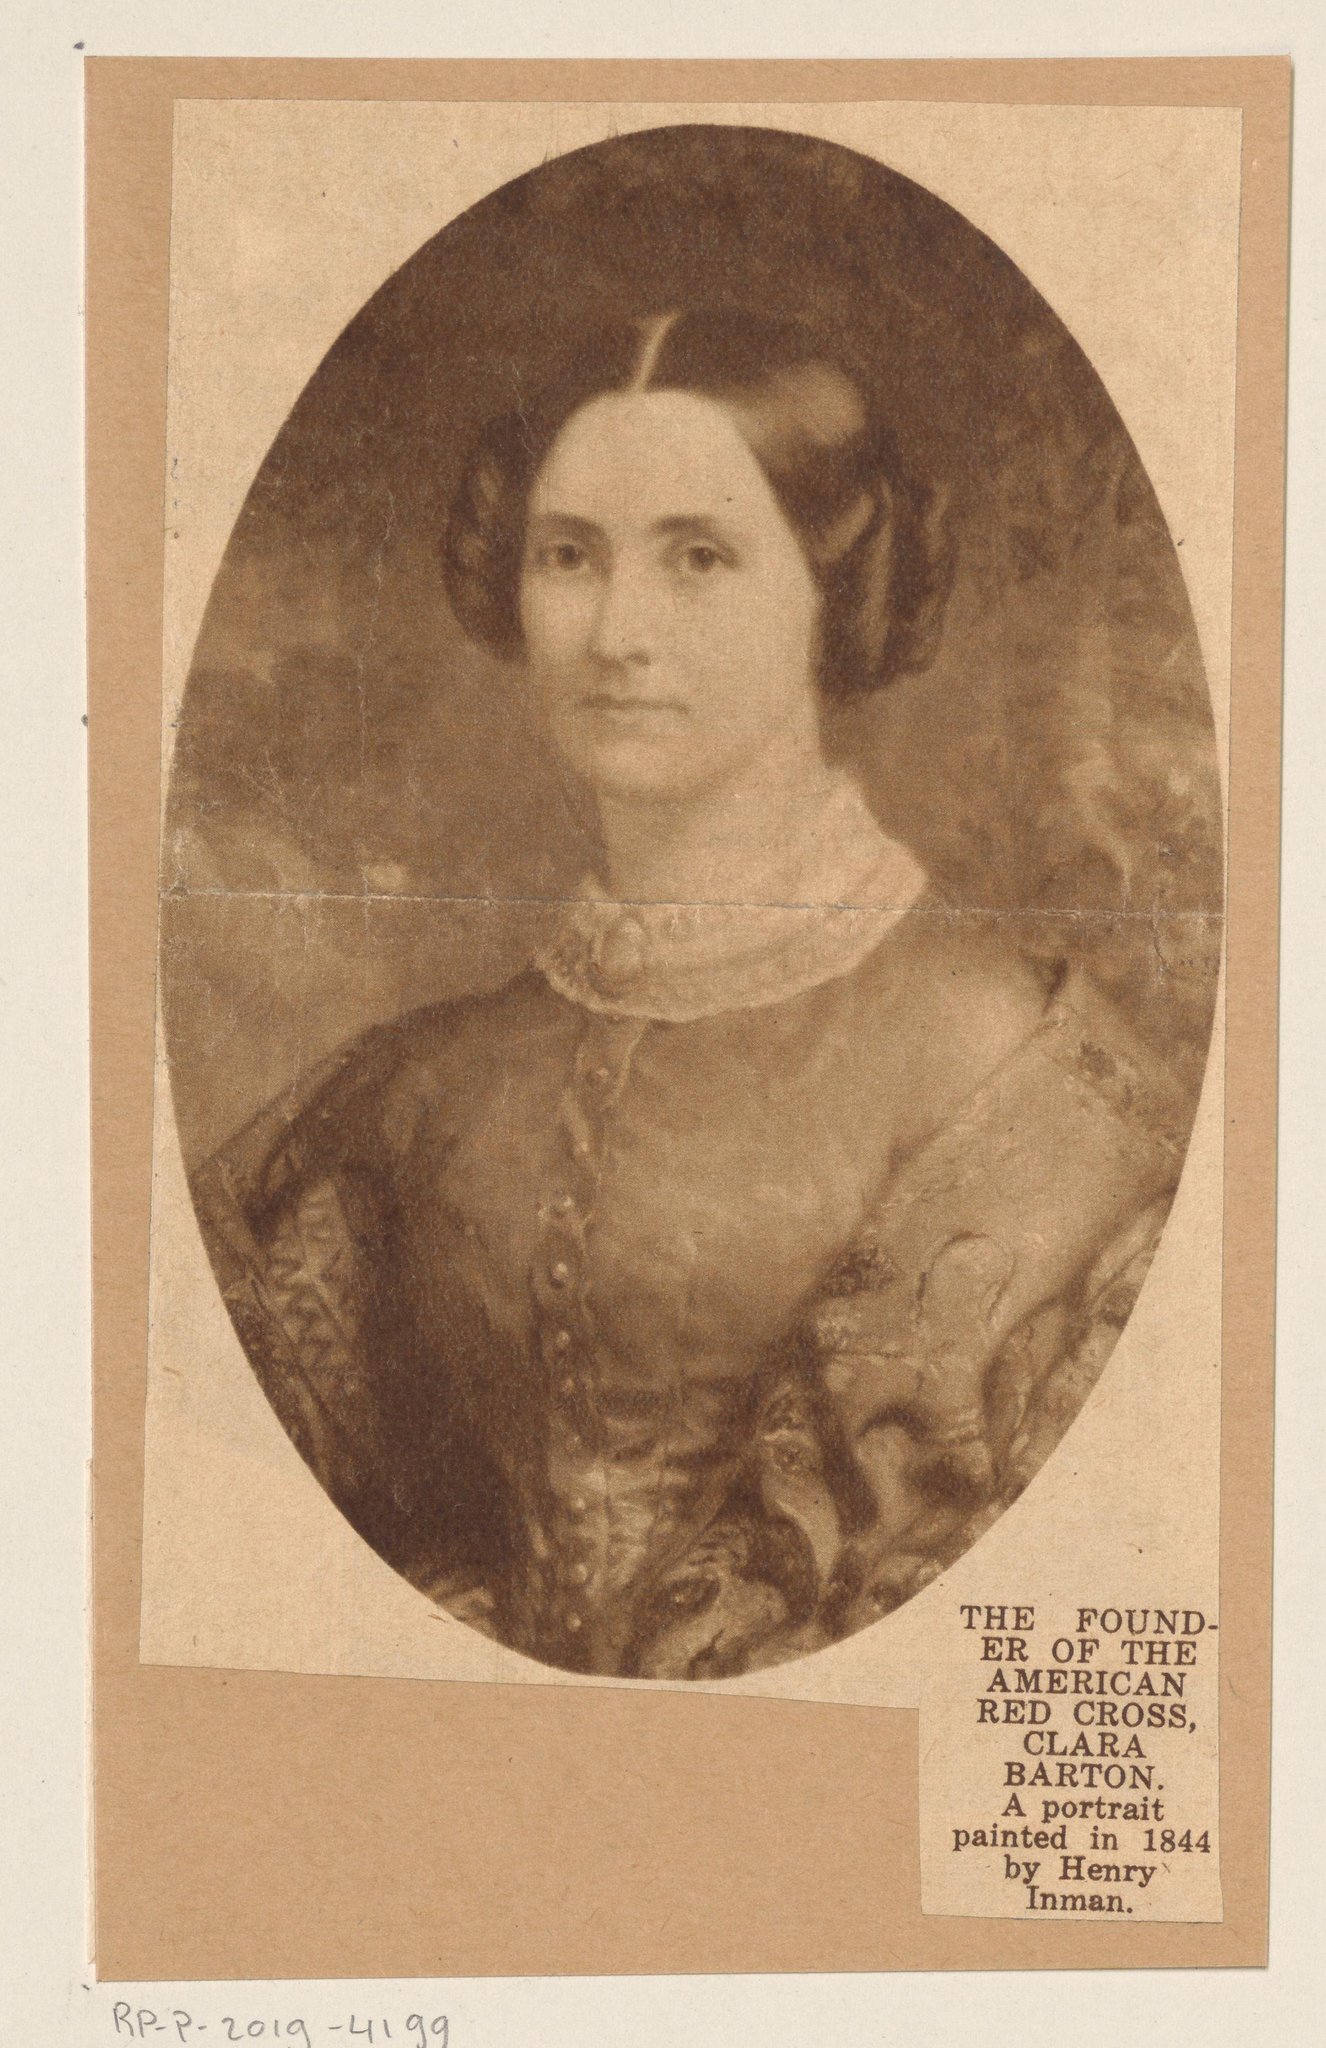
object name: photomechanical print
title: Portret van Clara Barton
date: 1880-1899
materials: paper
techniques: rotogravure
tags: historical persons - bb - woman